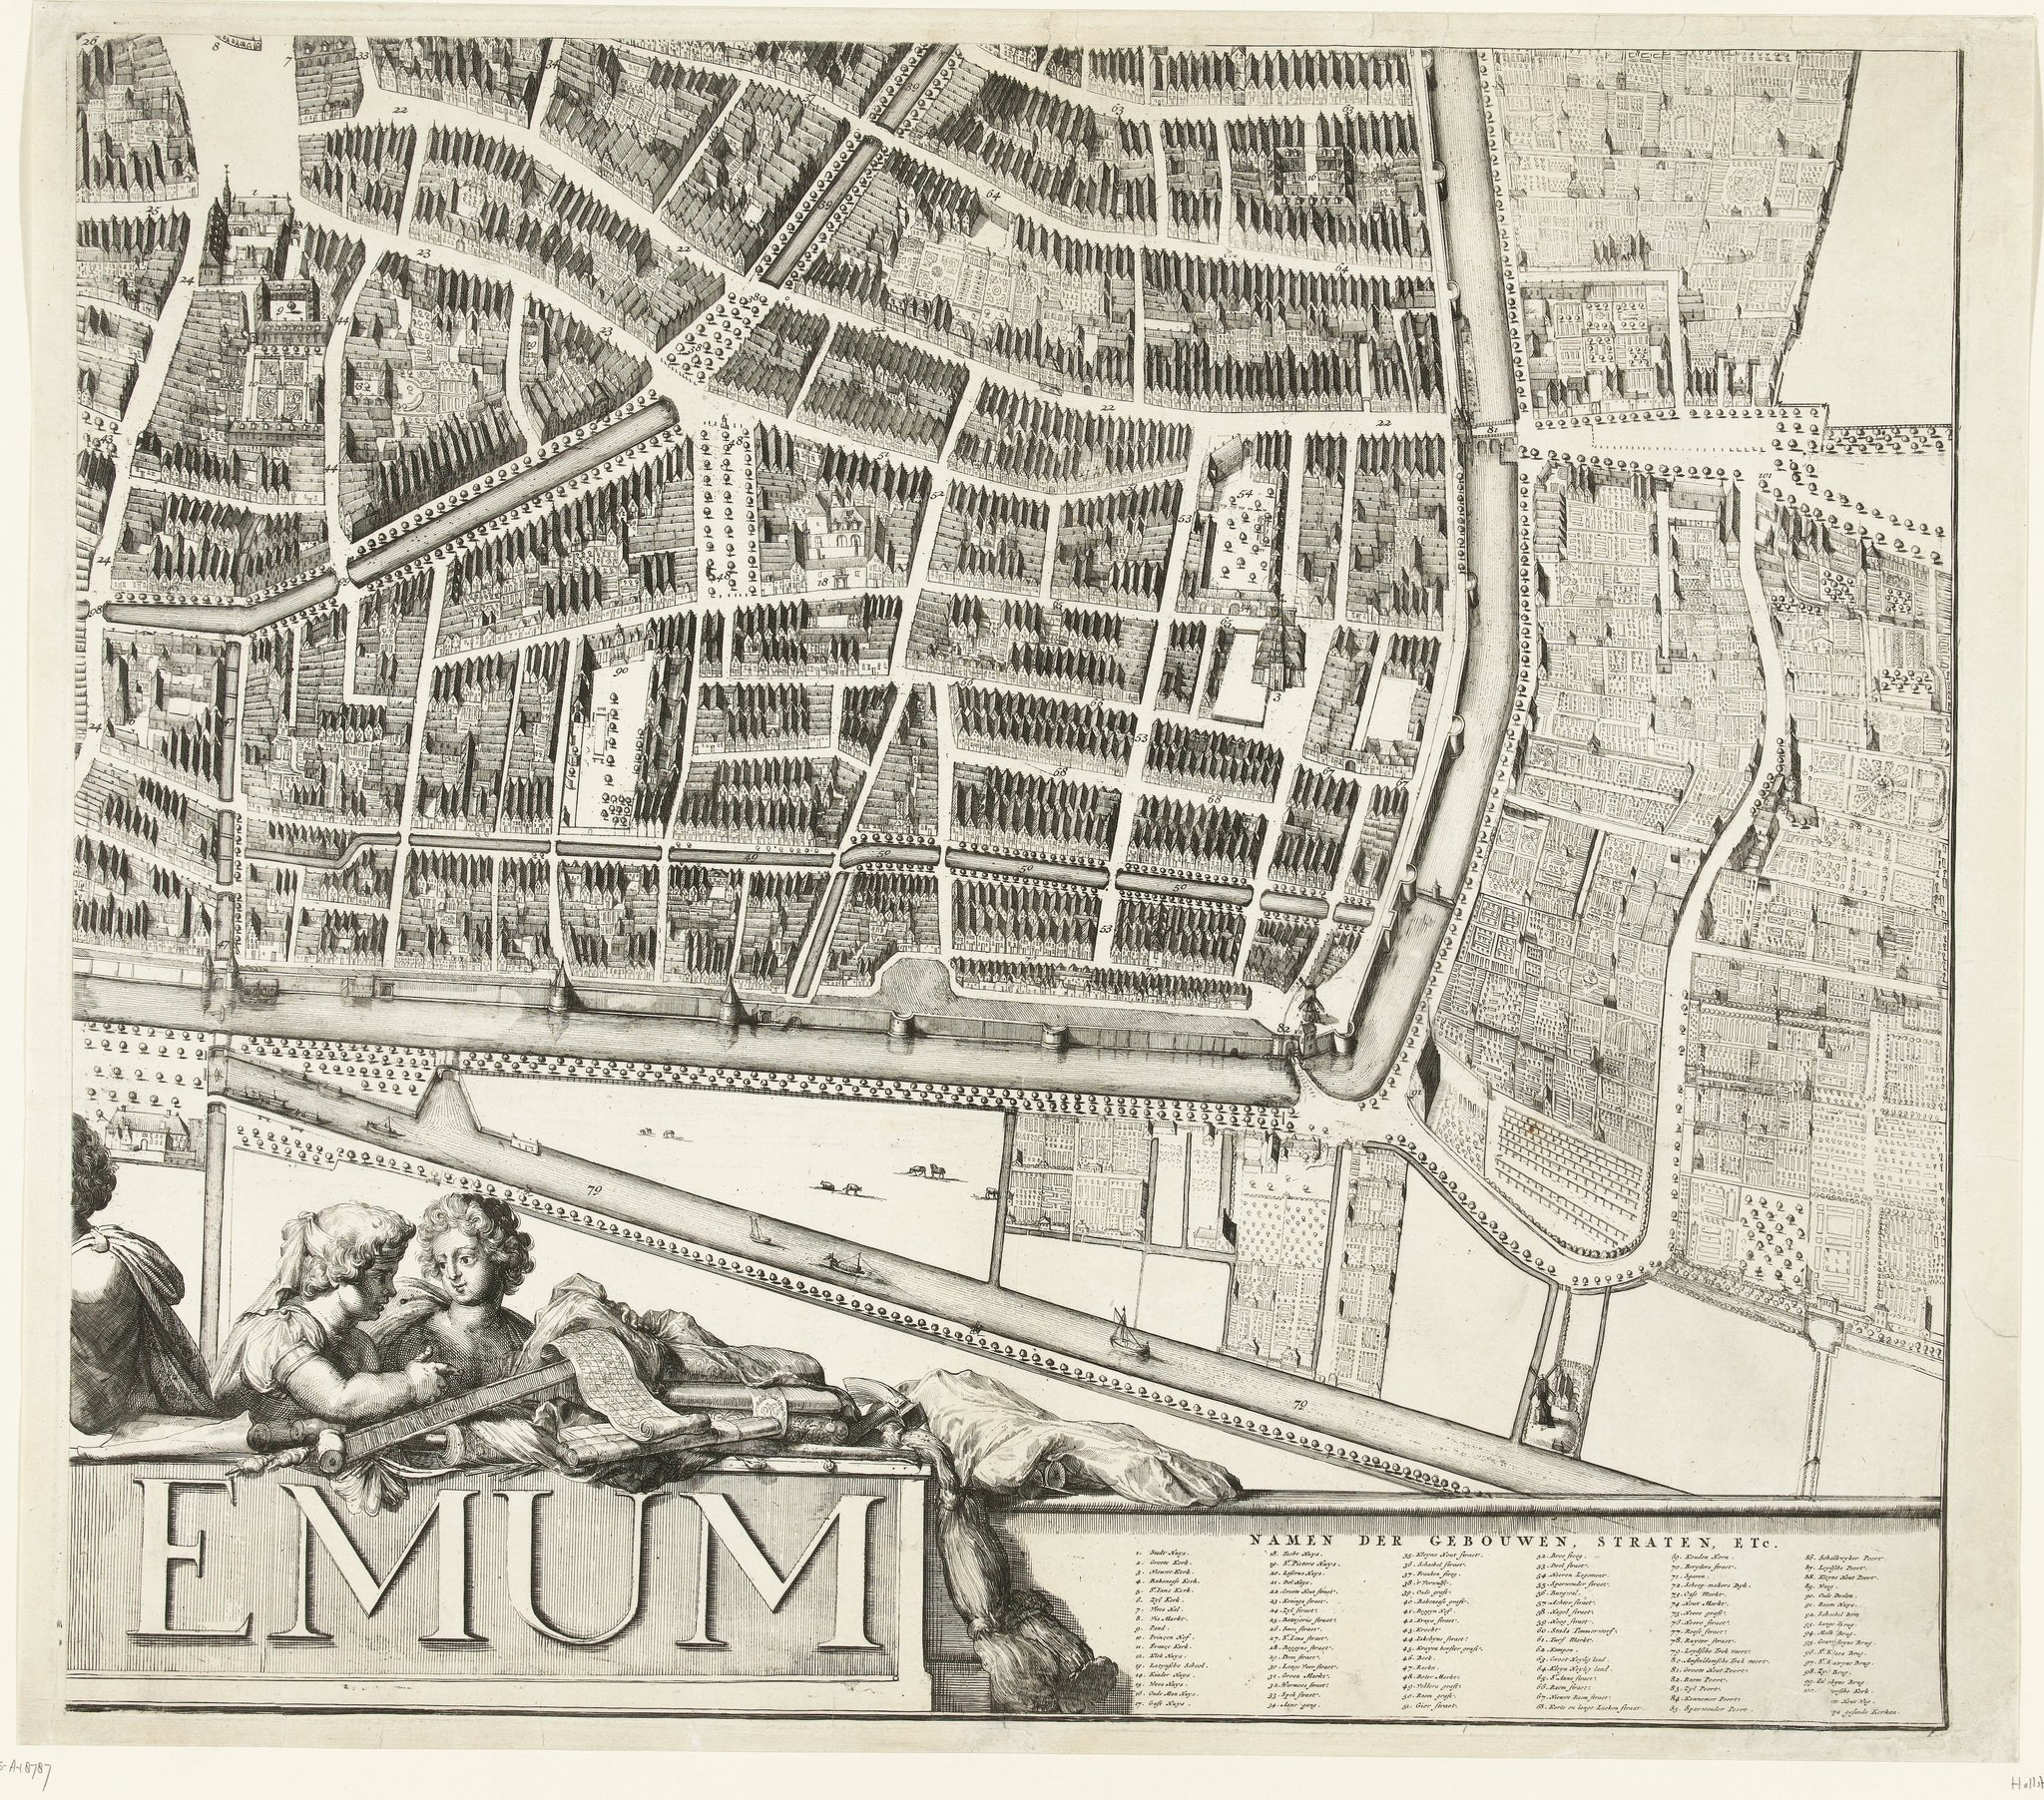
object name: print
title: Deel van de plattegrond van Haarlem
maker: romeyn de hooghe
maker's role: draughtsman, goldsmith, painter, print maker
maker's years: 1645-1708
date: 1688-1689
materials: paper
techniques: etching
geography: haarlem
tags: maps of cities, haarlem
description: Een van de vier bladen die samen de plattegrond van Haarlem voorstellen. Linksonder deel van tekst (Harl)emum en twee putti met rollen met stof. Rechtsonder een genummerde lijst van namen van gebouwen en straten die corresponderen met cijfers op de plattegrond.